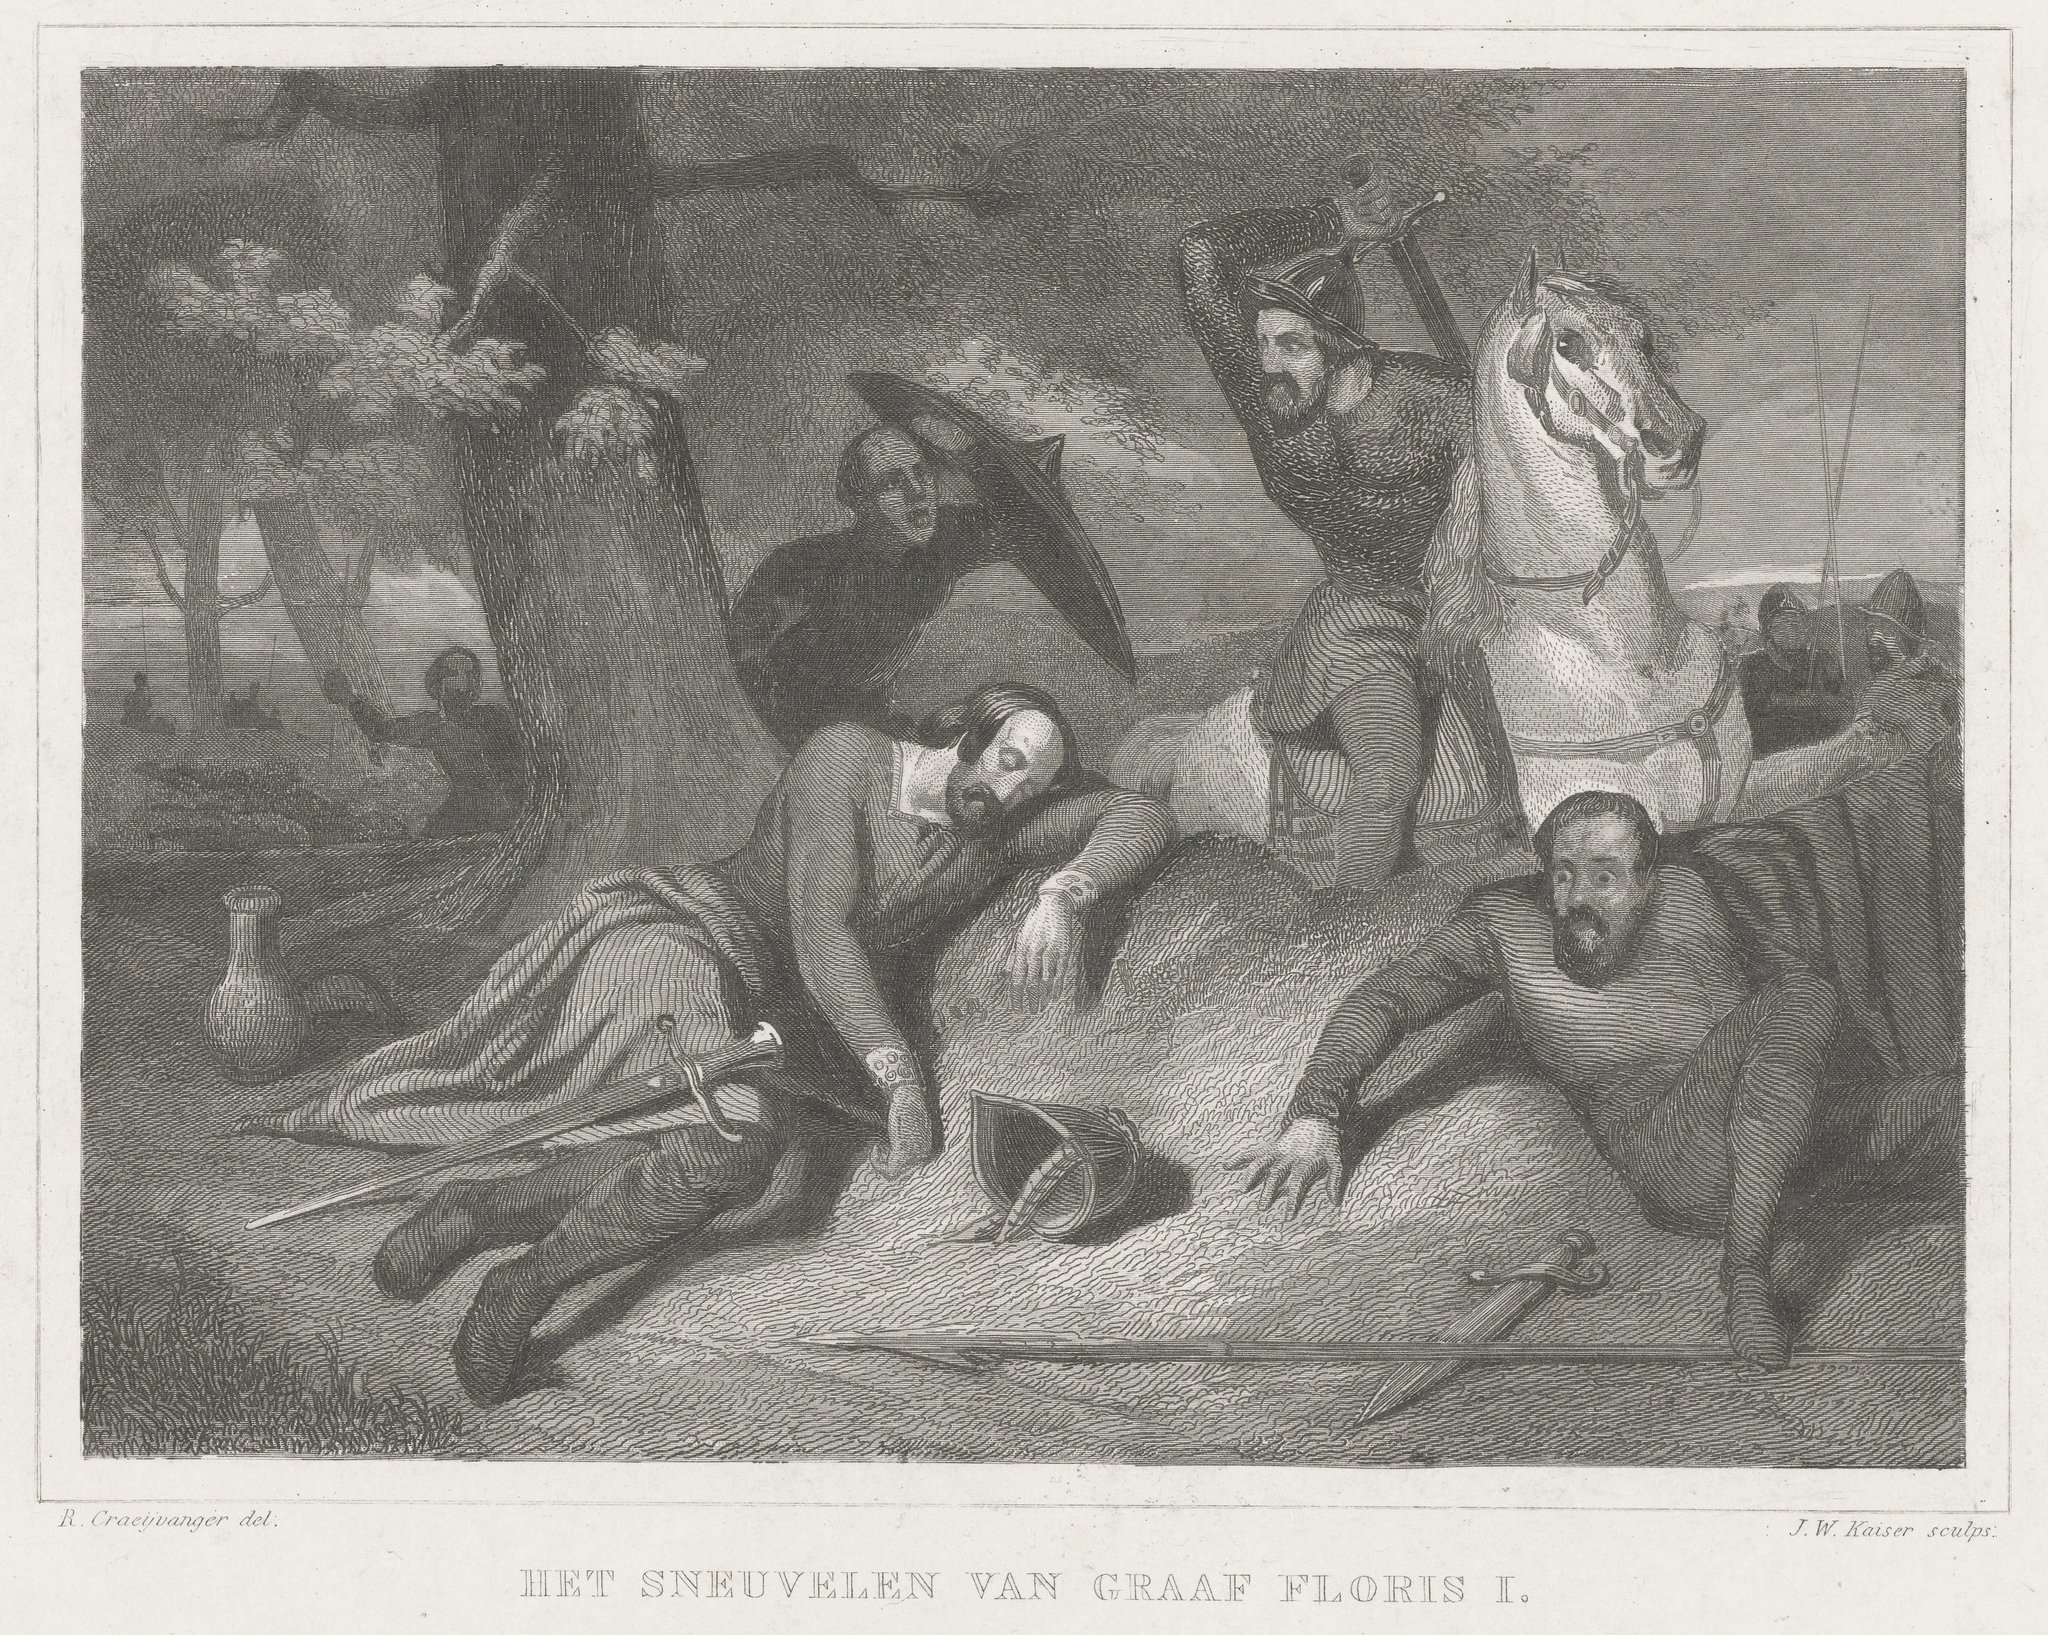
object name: print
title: Het sneuvelen van graaf Floris I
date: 1839-1841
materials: paper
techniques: engraving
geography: netherlands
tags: violent death, being killed; being mishandled and maltreated; seeking death, attempt, political murder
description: Illustratie voor: J.P. Arend, Algemeene geschiedenis des vaderlands, Amsterdam, 5 delen, 1840-1882, dl. 2.1, p. 71.